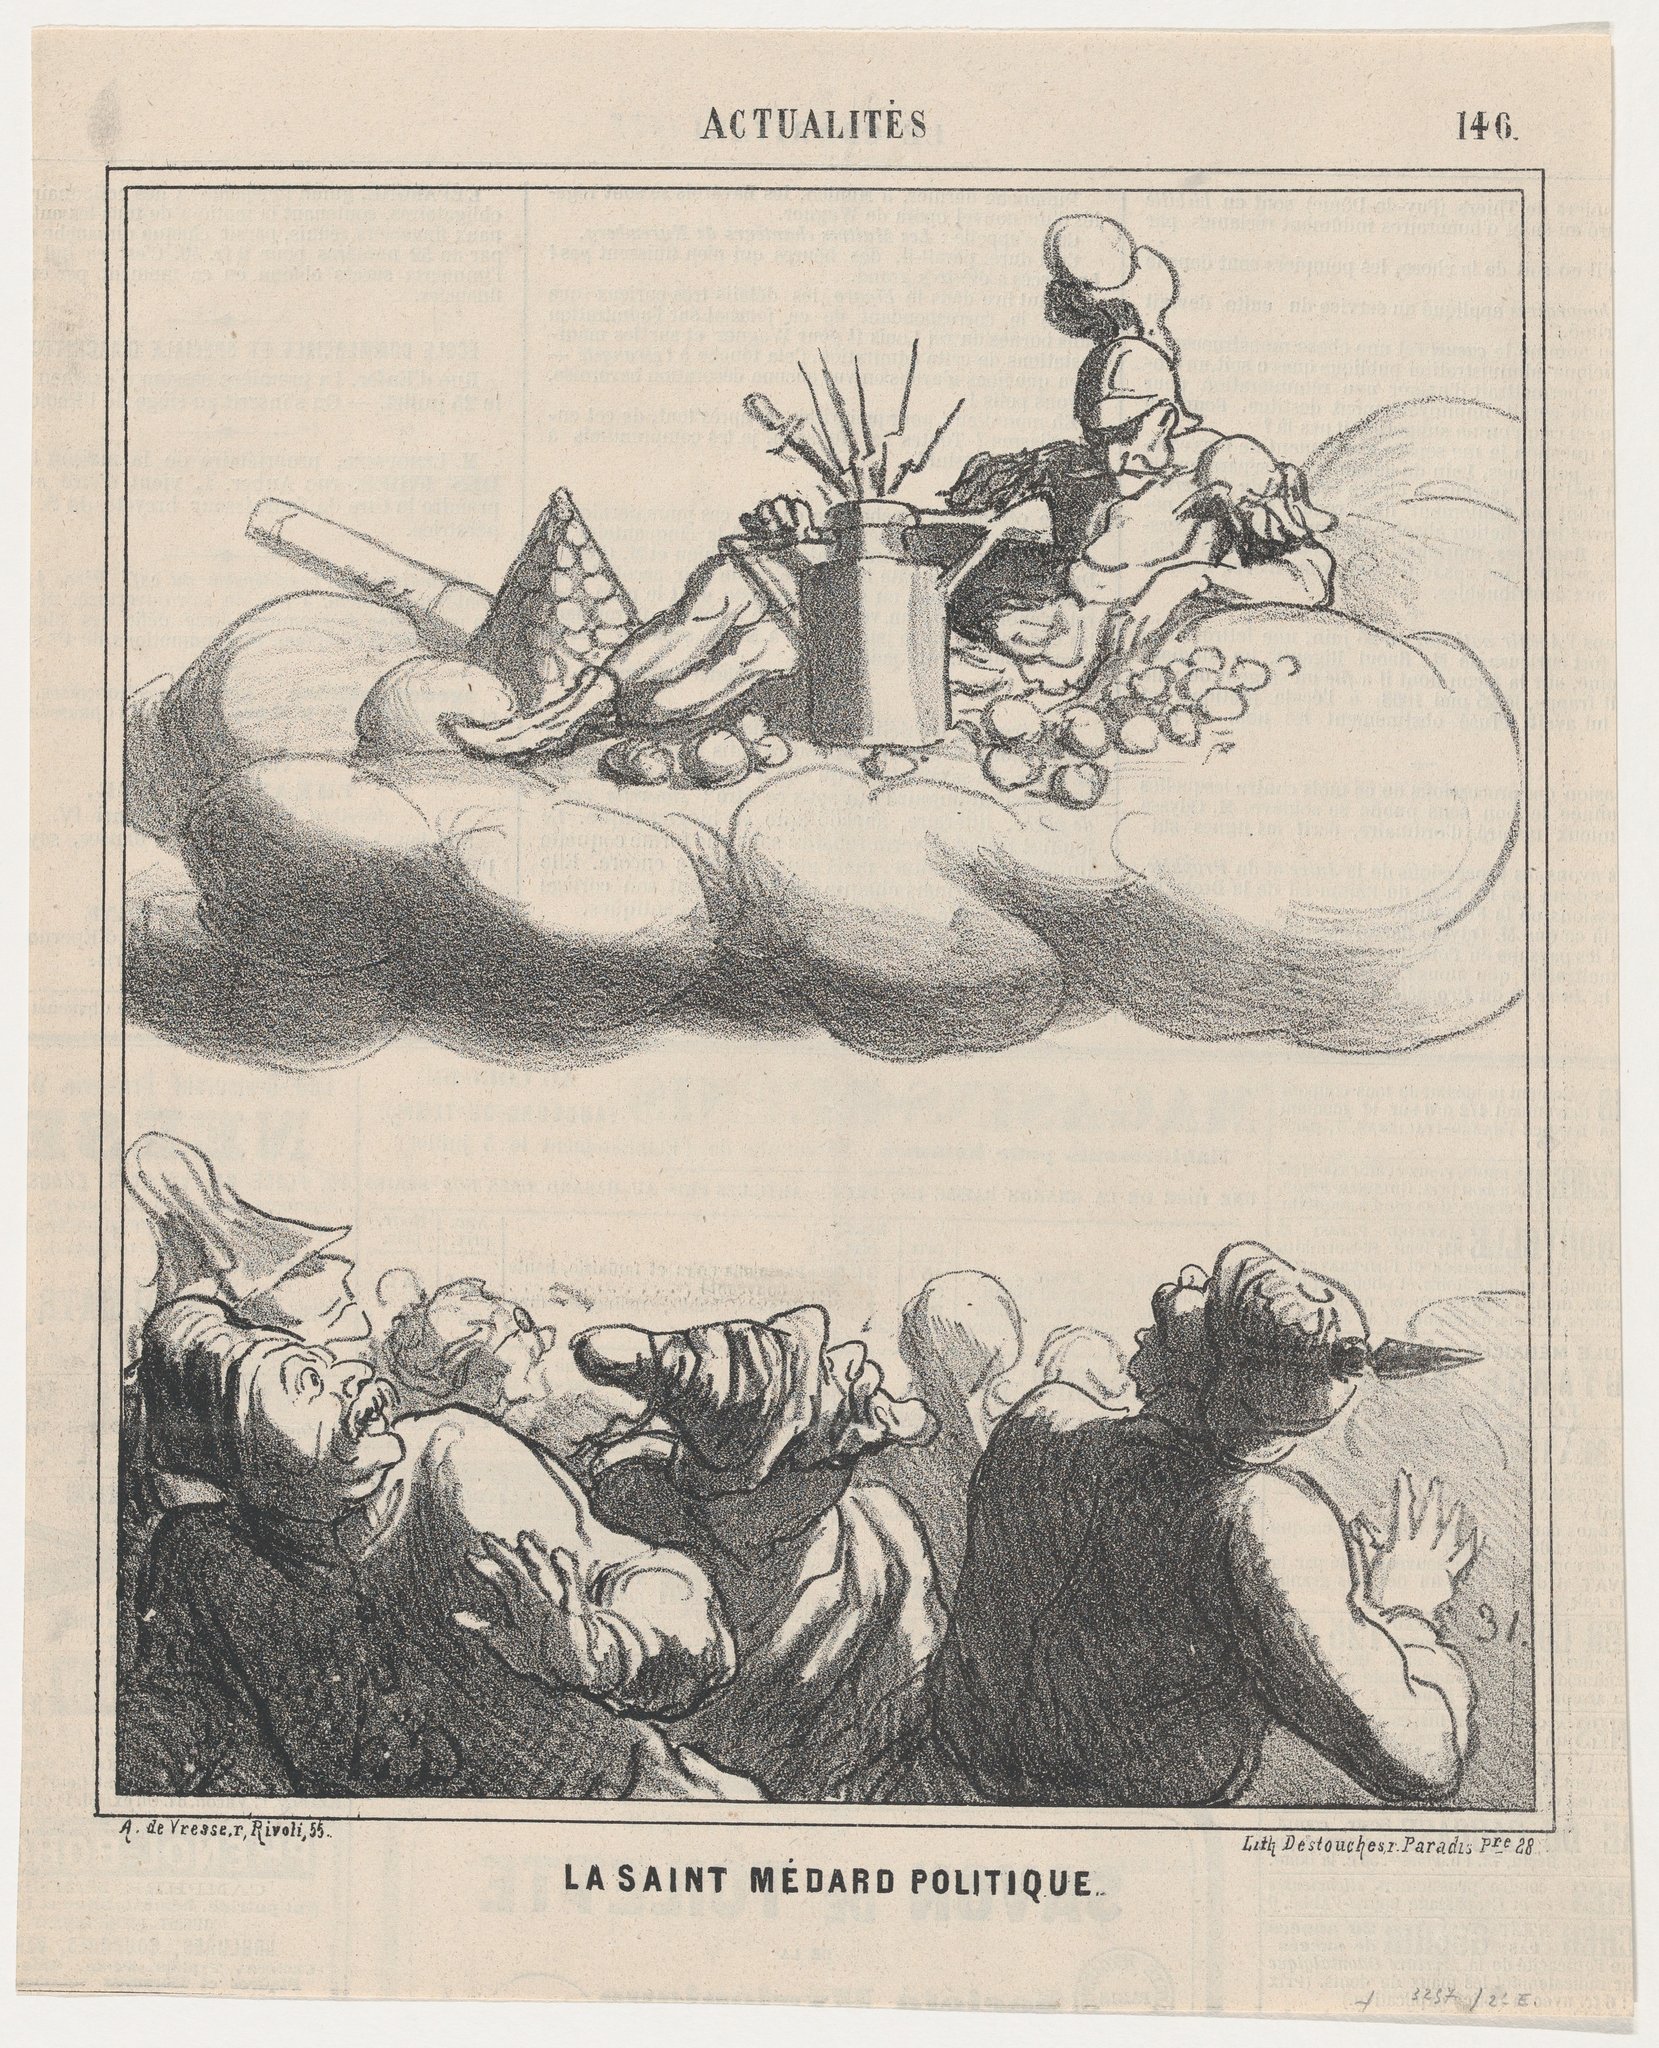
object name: print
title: Saint Médard of politics, from 'News of the day,' published in "Le Charivari"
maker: honoré daumier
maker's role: artist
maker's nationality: french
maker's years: 1808-1879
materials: paper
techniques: lithograph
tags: satire,men